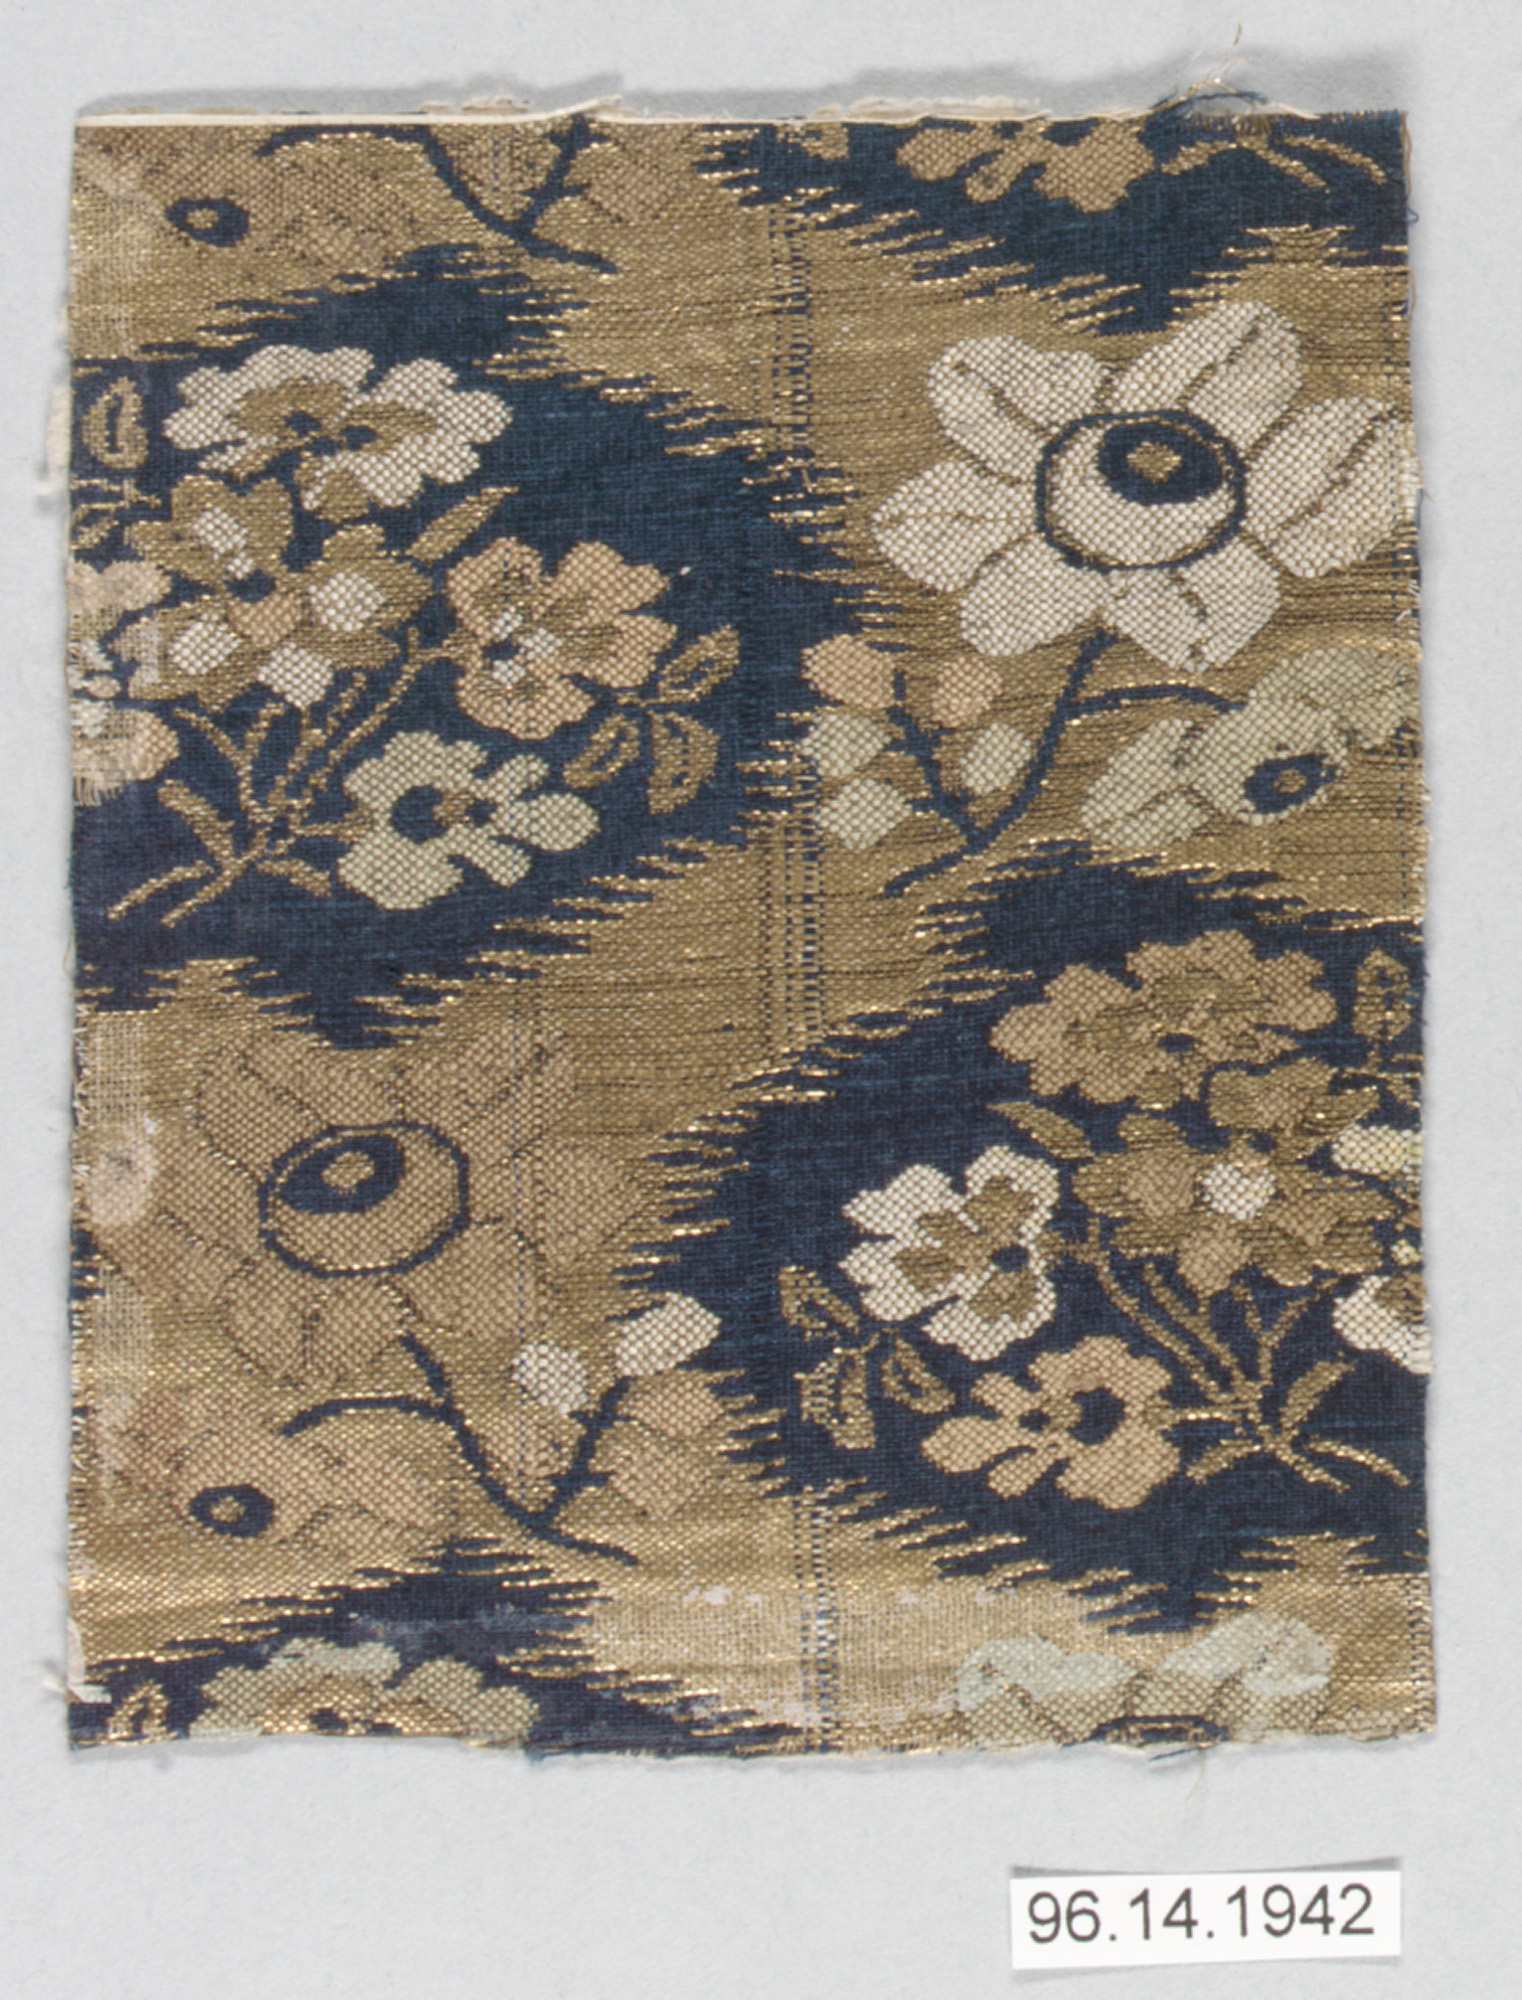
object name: piece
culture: japanese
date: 1767-1800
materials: cotton, silk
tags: flowers